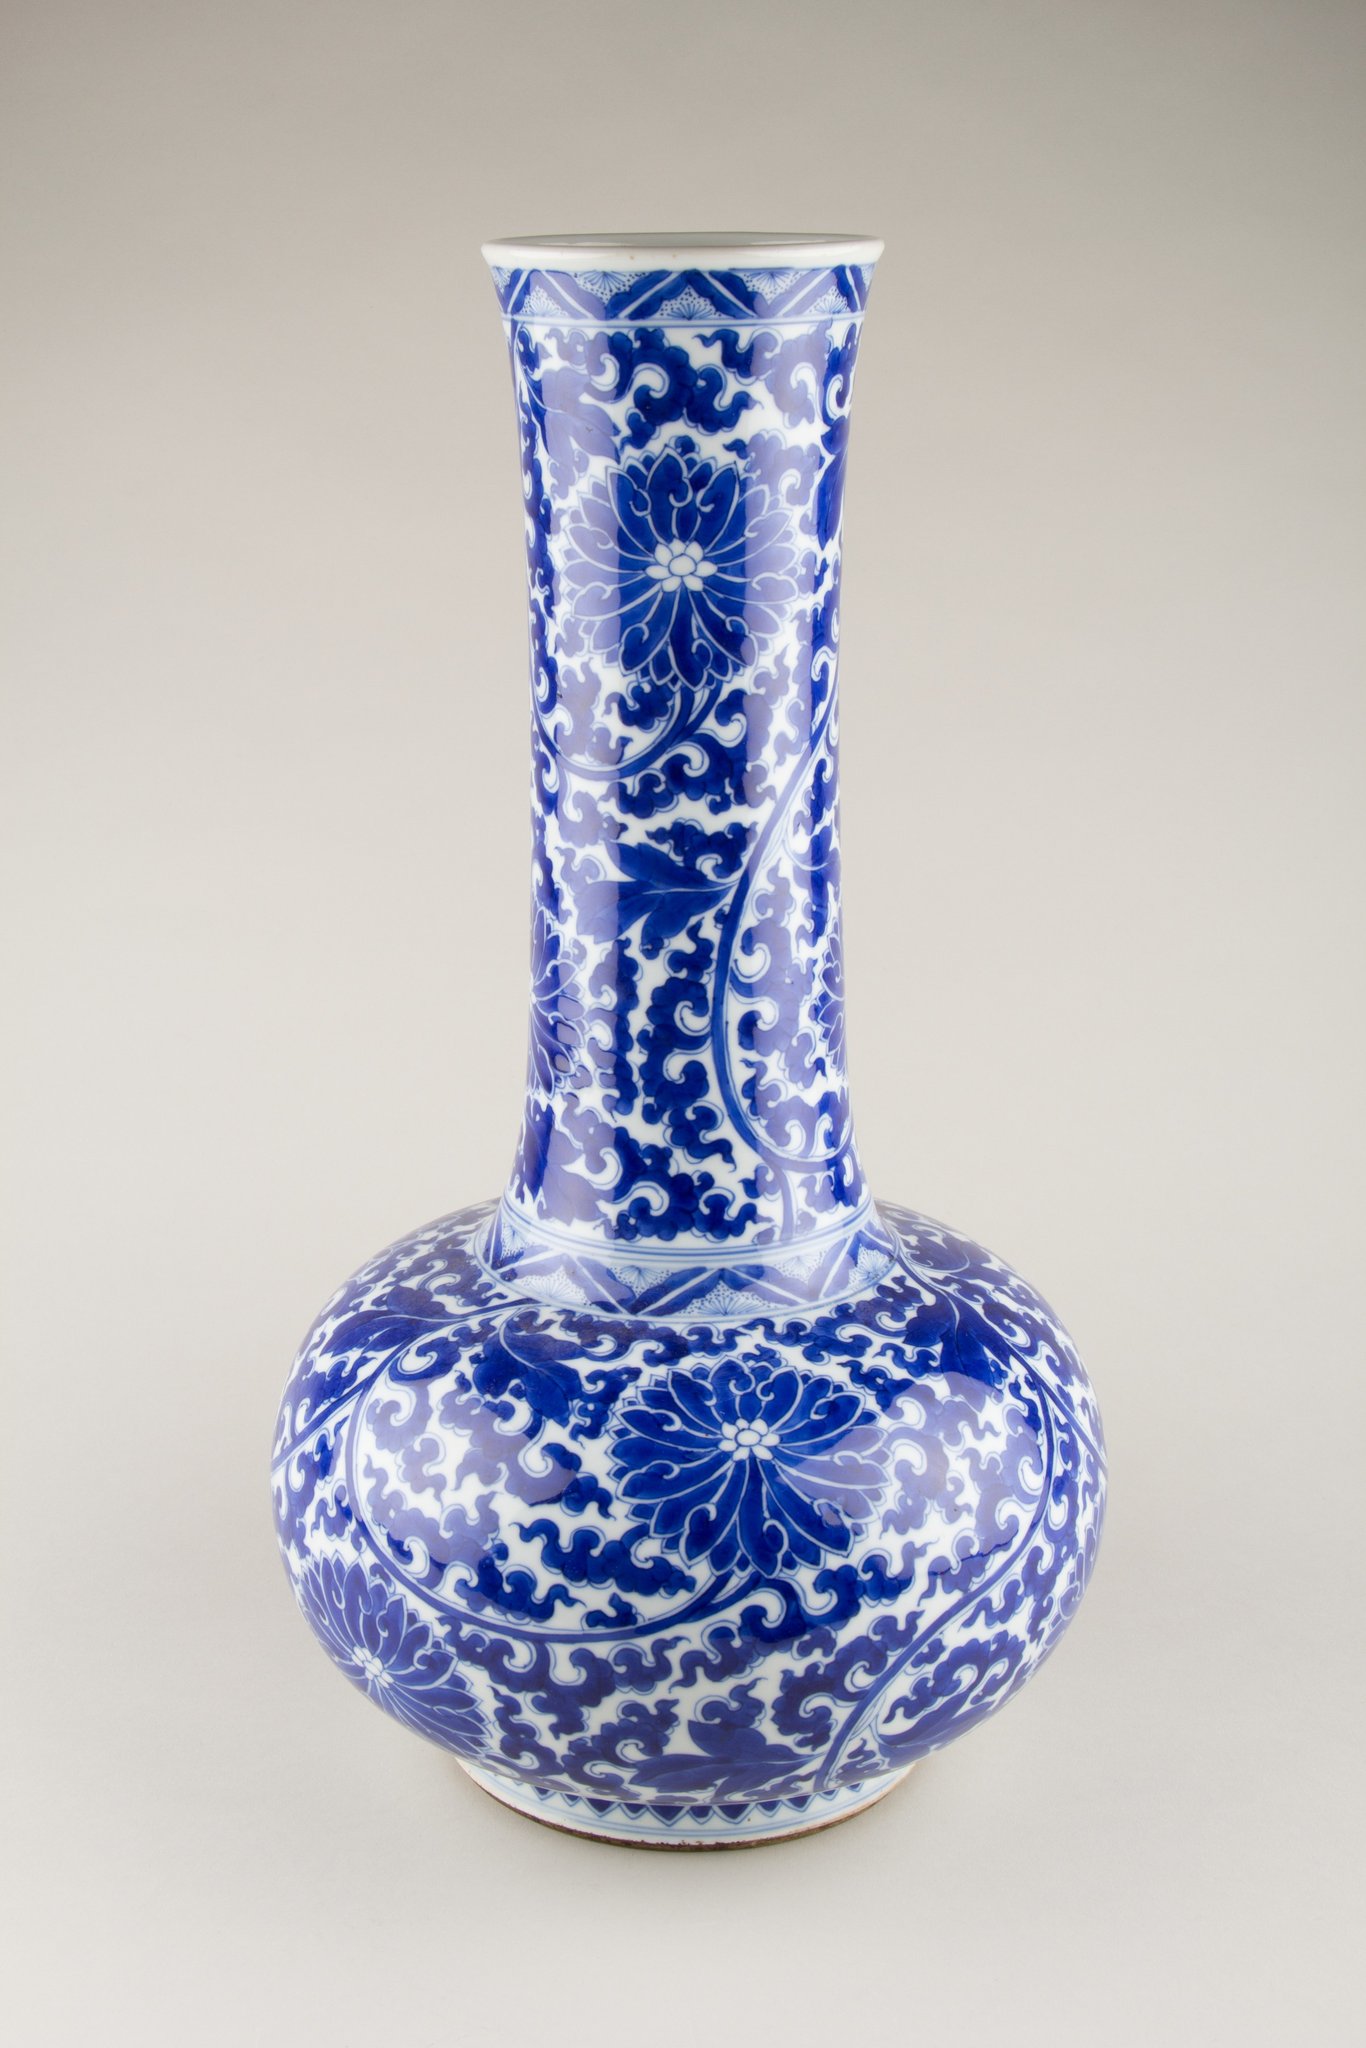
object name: bottle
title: Bottle vase with floral scrolls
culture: chinese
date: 1667-1733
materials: cobalt, porcelain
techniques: painting, underglaze